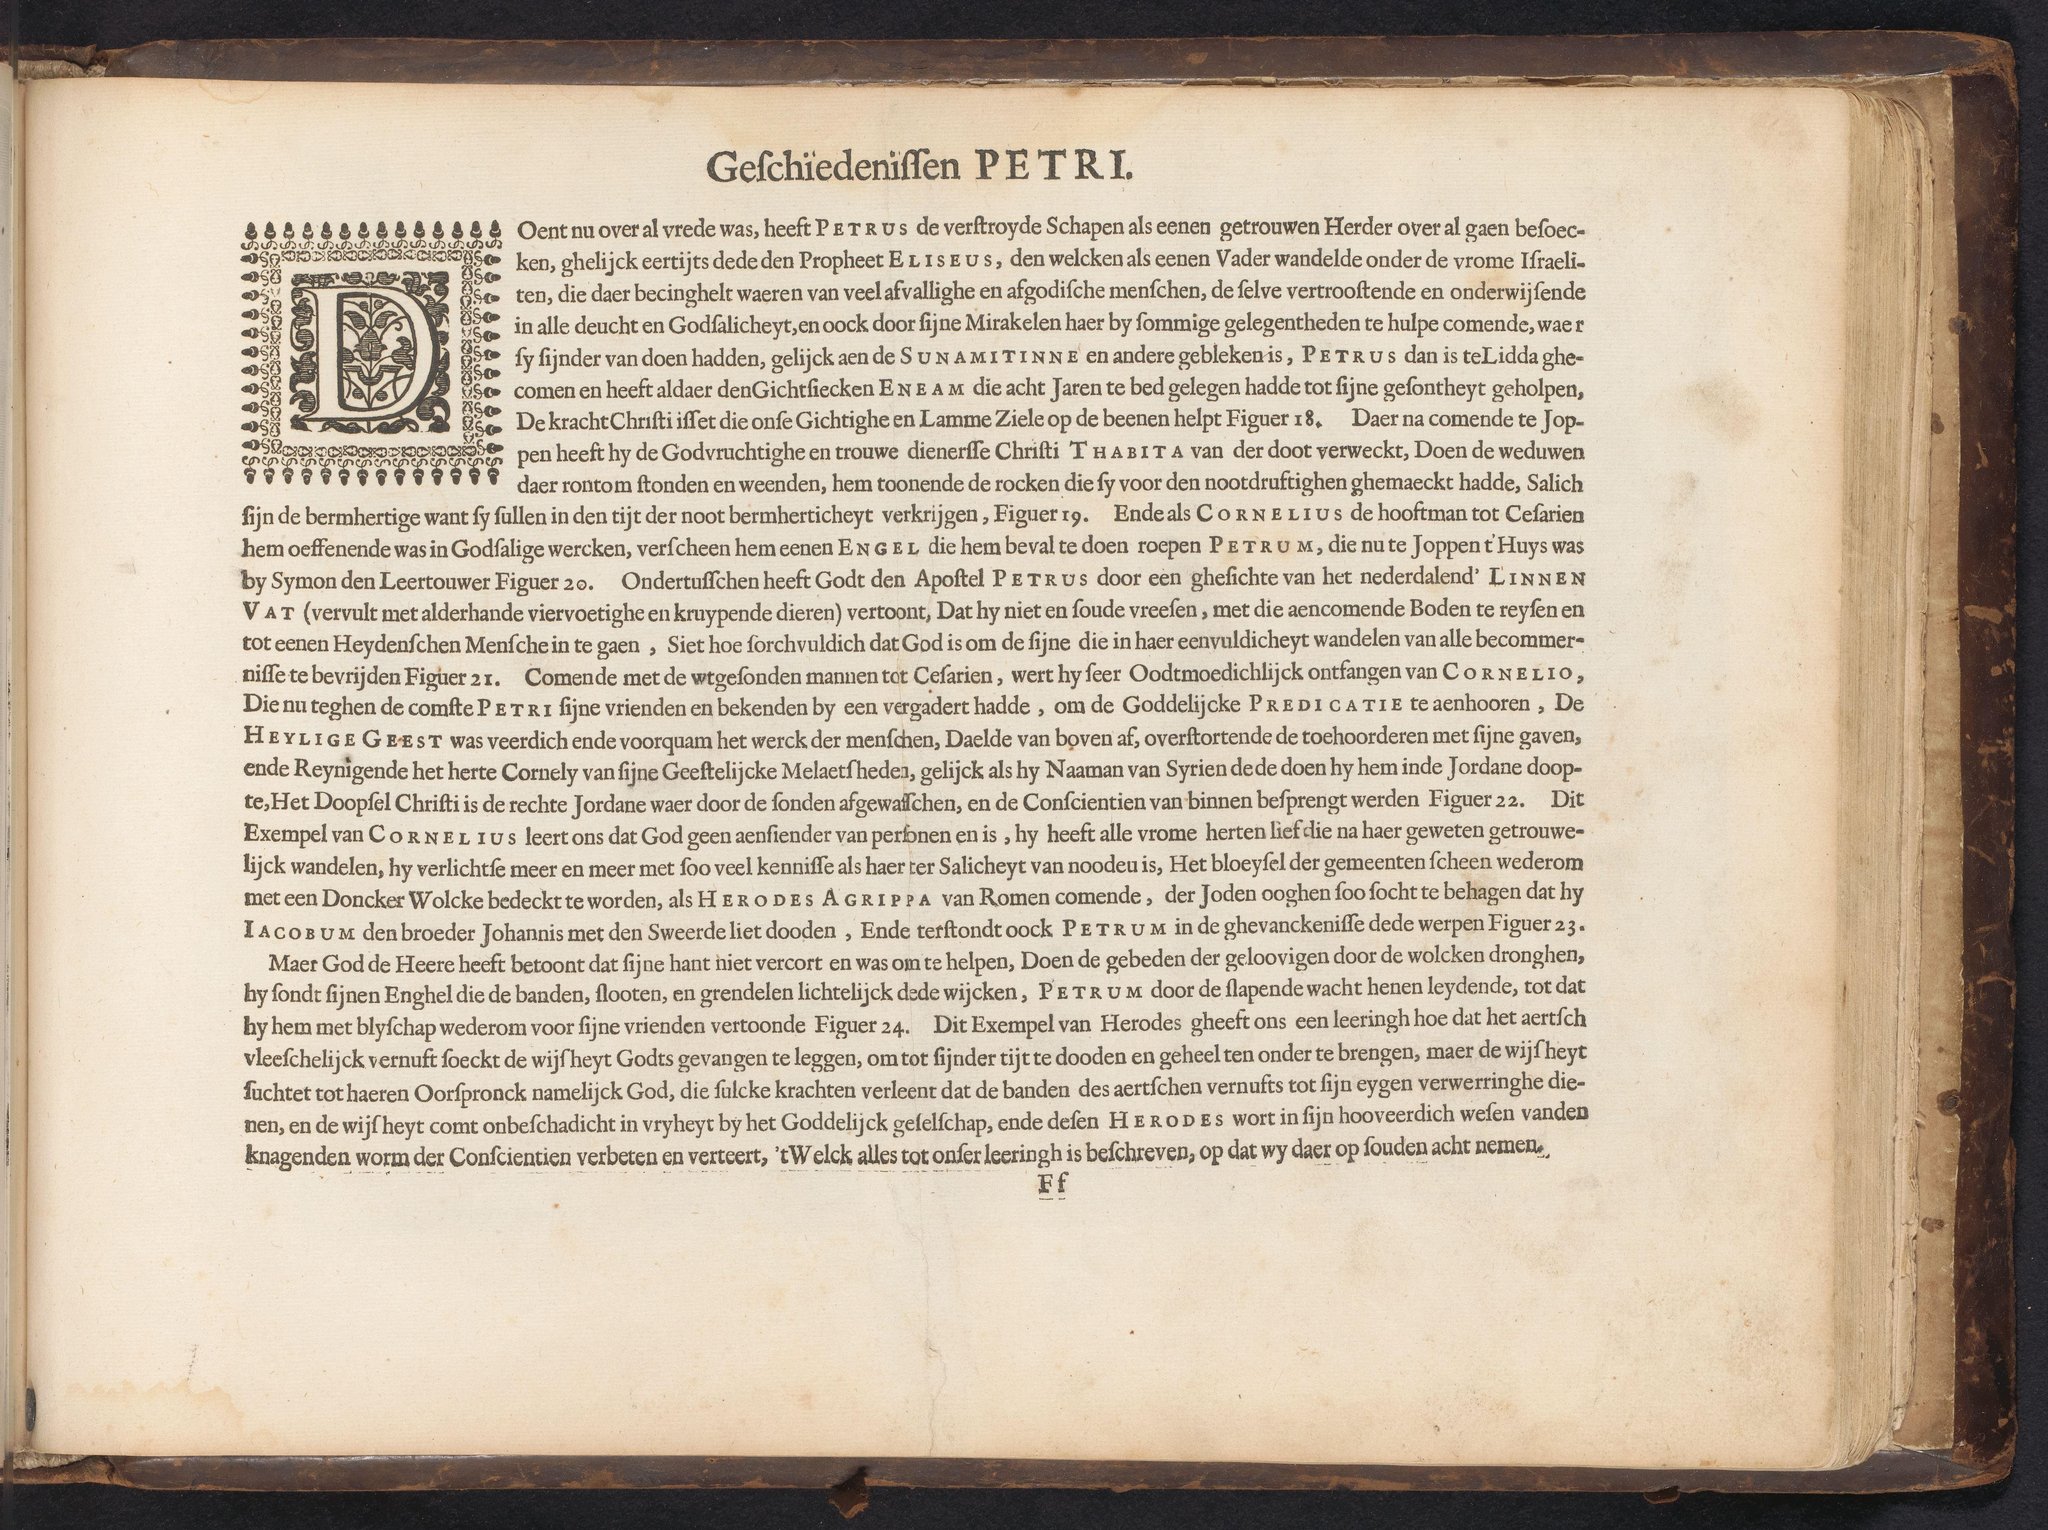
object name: text sheet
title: Den Grooten Figuer-Bibel (...)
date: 1646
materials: paper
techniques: letterpress printing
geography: alkmaar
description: Tekstblad bij een serie prenten over de geschiedenis van Petrus. Linksboven initiaal D. Dit blad maakt deel uit van een album.